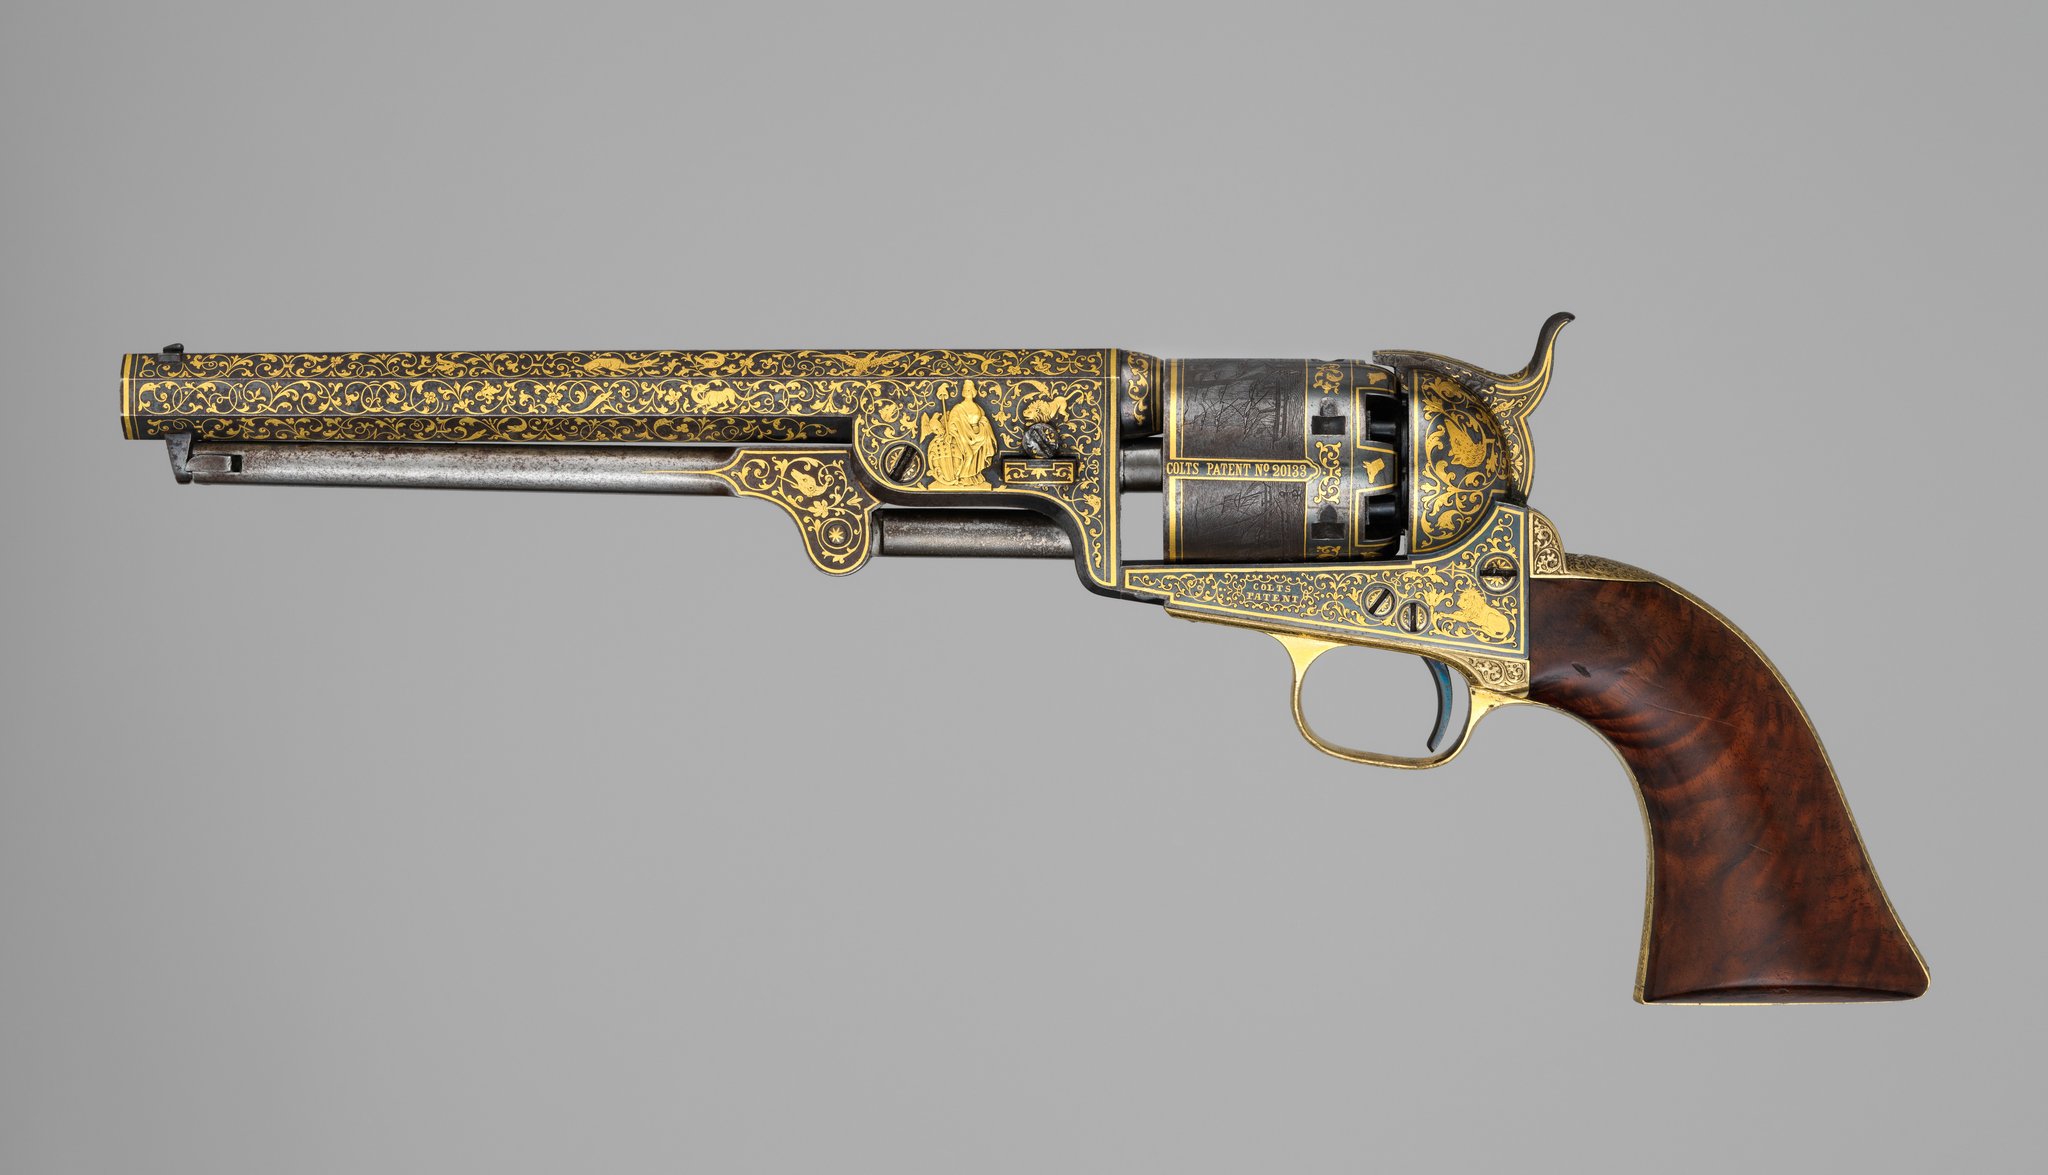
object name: revolver with case and accessory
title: Gold-inlaid Colt Model 1851 Navy Revolver (serial no. 20133), with Case and Accessories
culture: american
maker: samuel colt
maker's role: manufacturer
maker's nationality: american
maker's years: 1814-1862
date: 1853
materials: bone, copper alloy, cork, glass, gold, paper, pewter, steel, textile, wood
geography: united states